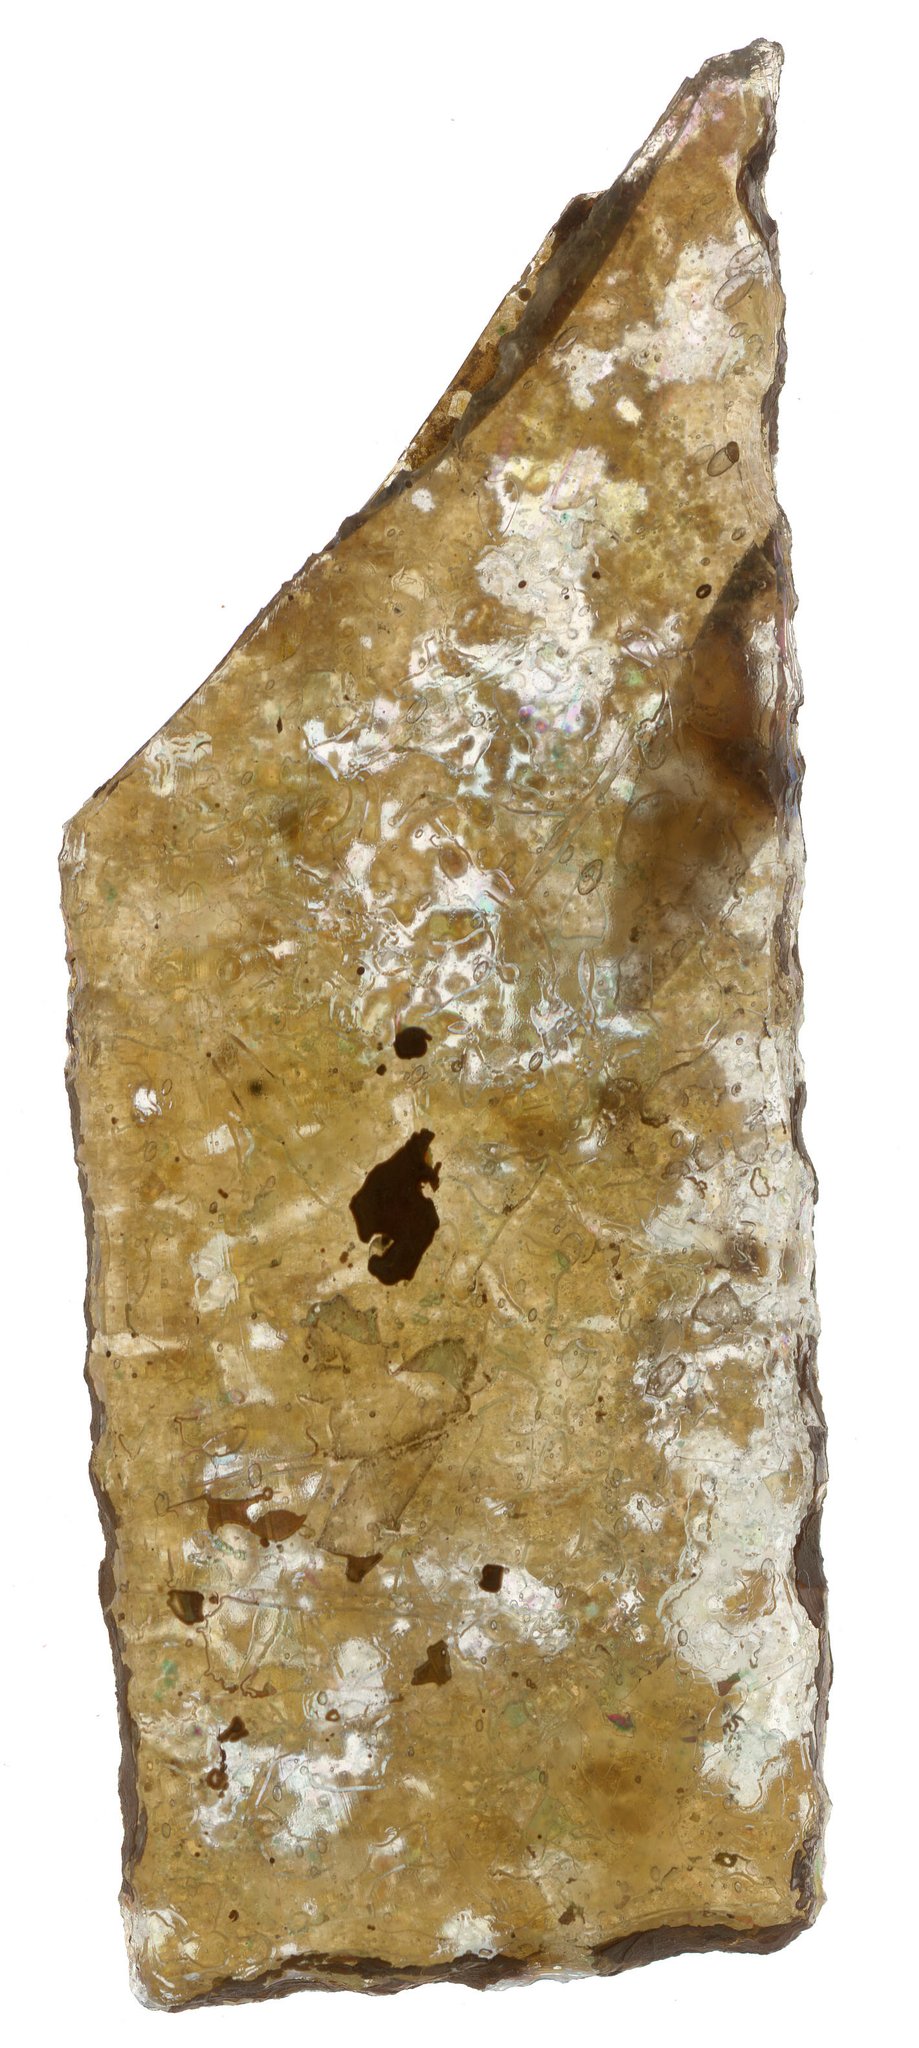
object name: fragment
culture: crusader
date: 1201-1300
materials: glass